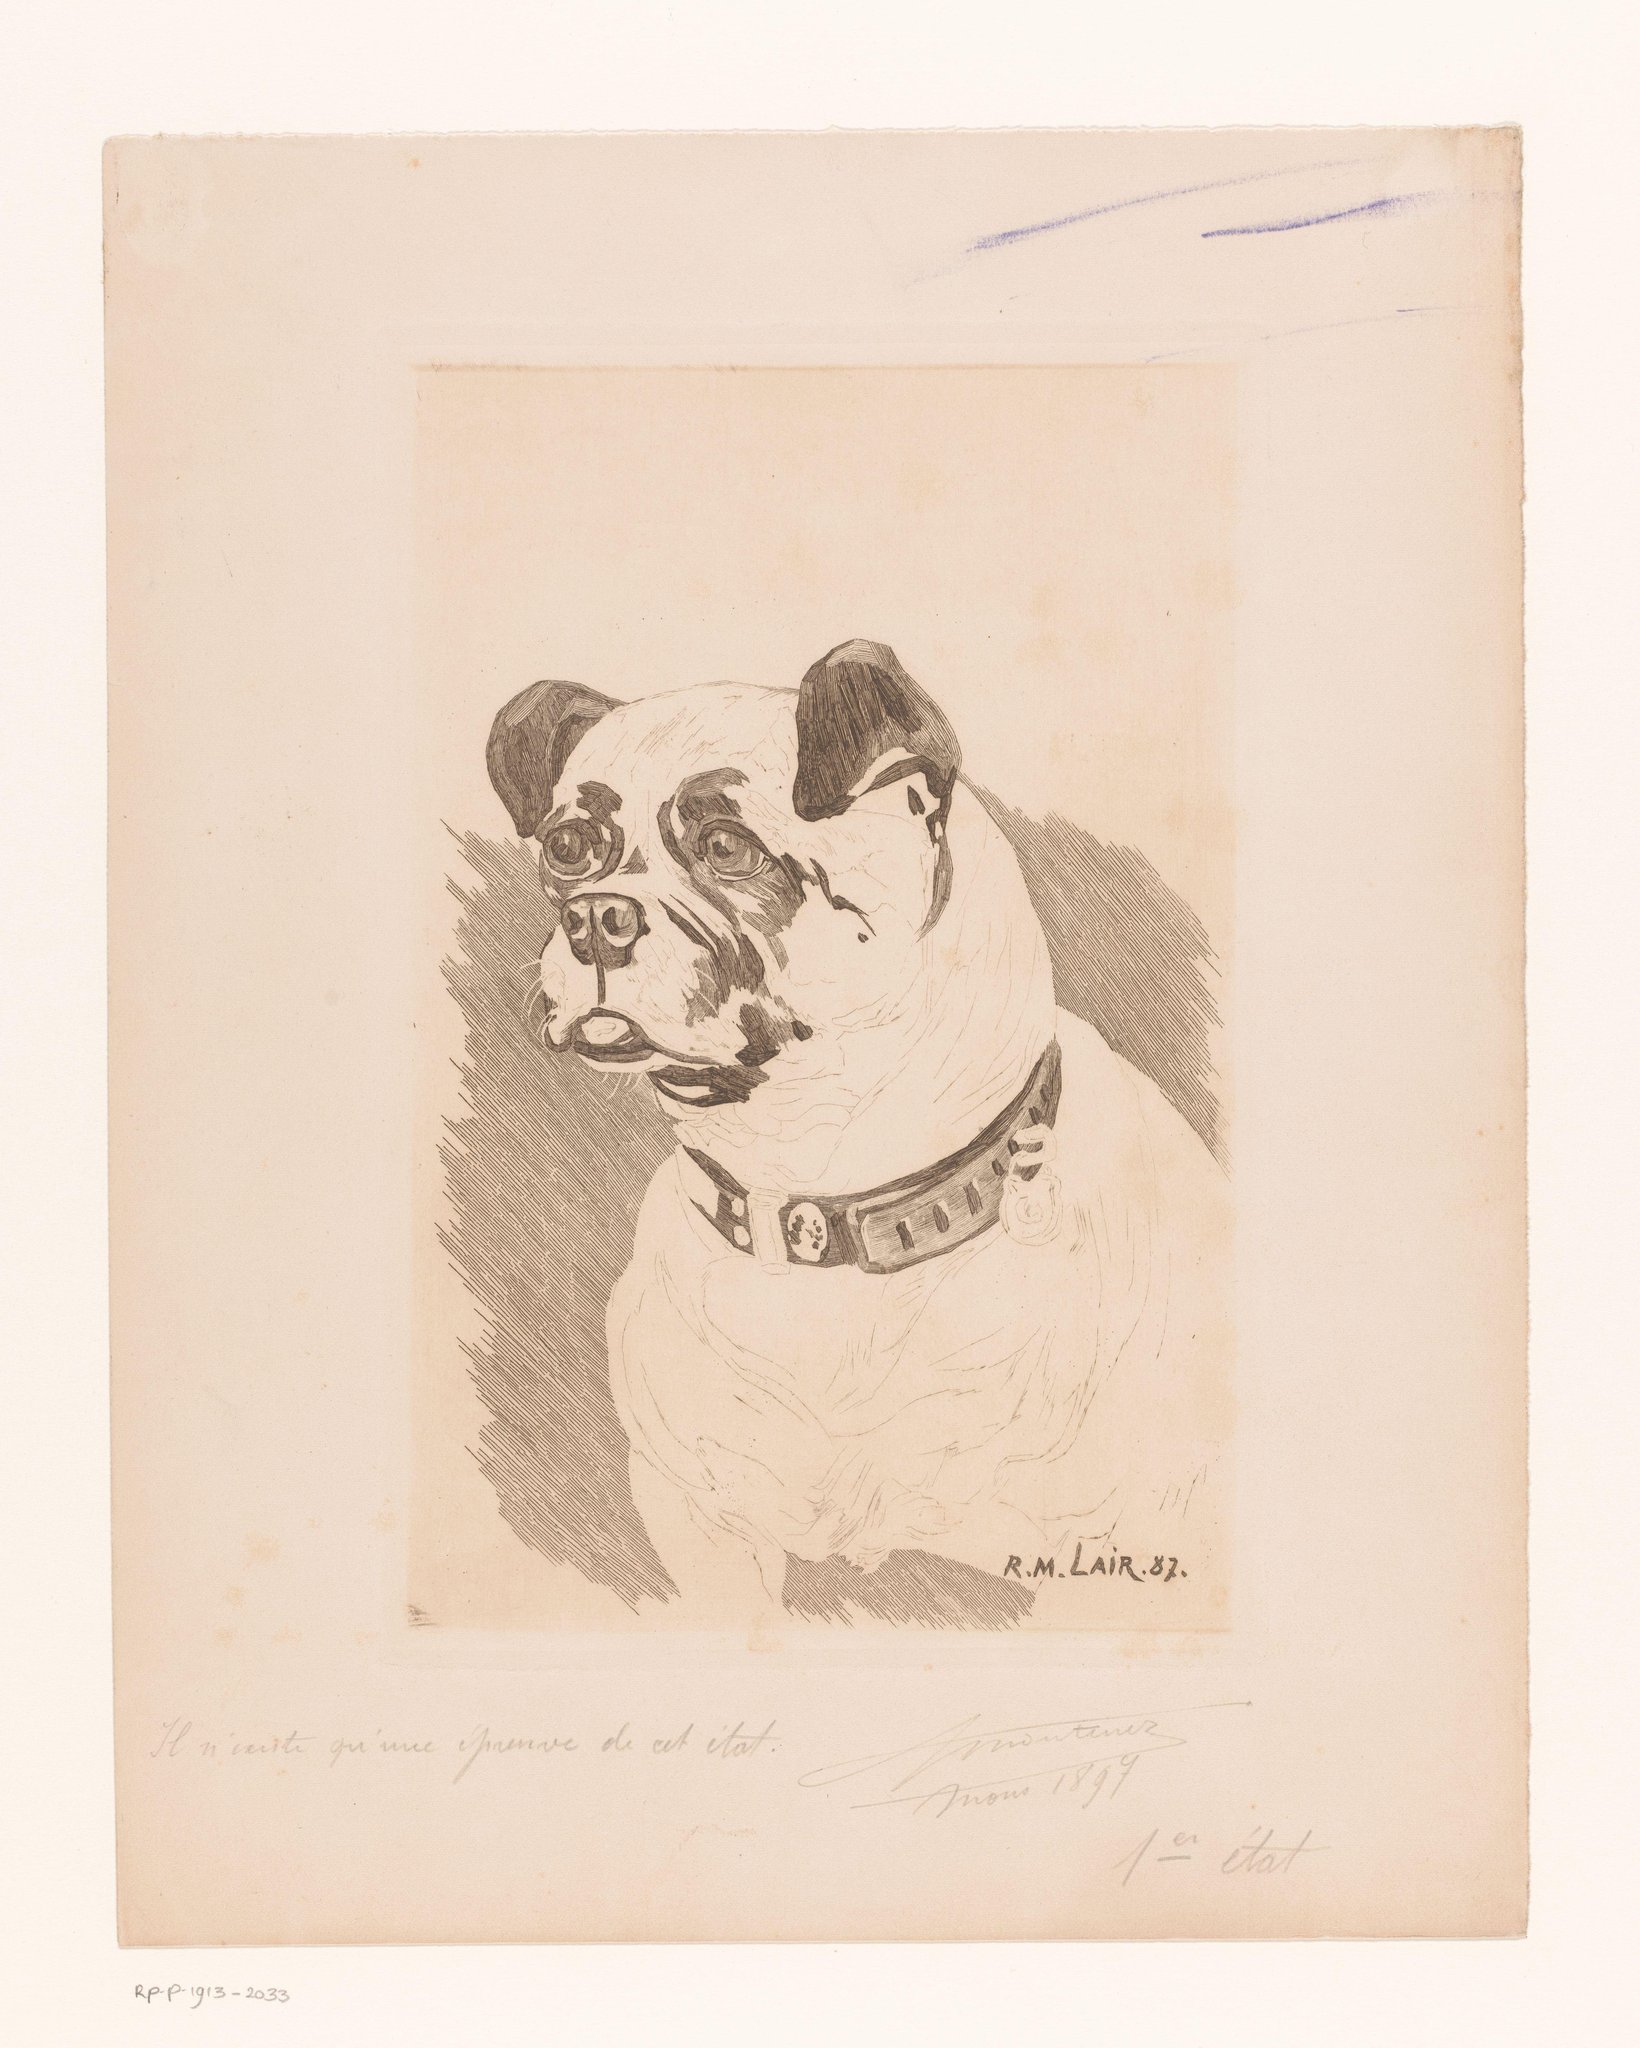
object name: print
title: Hond met halsband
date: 1897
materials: paper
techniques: etching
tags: collar (of a dog), dog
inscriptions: collector's mark: Lugt 2228, inscription: ‘El n'existe qu'une épreuve de cit état; Mons 1897; 1er état’